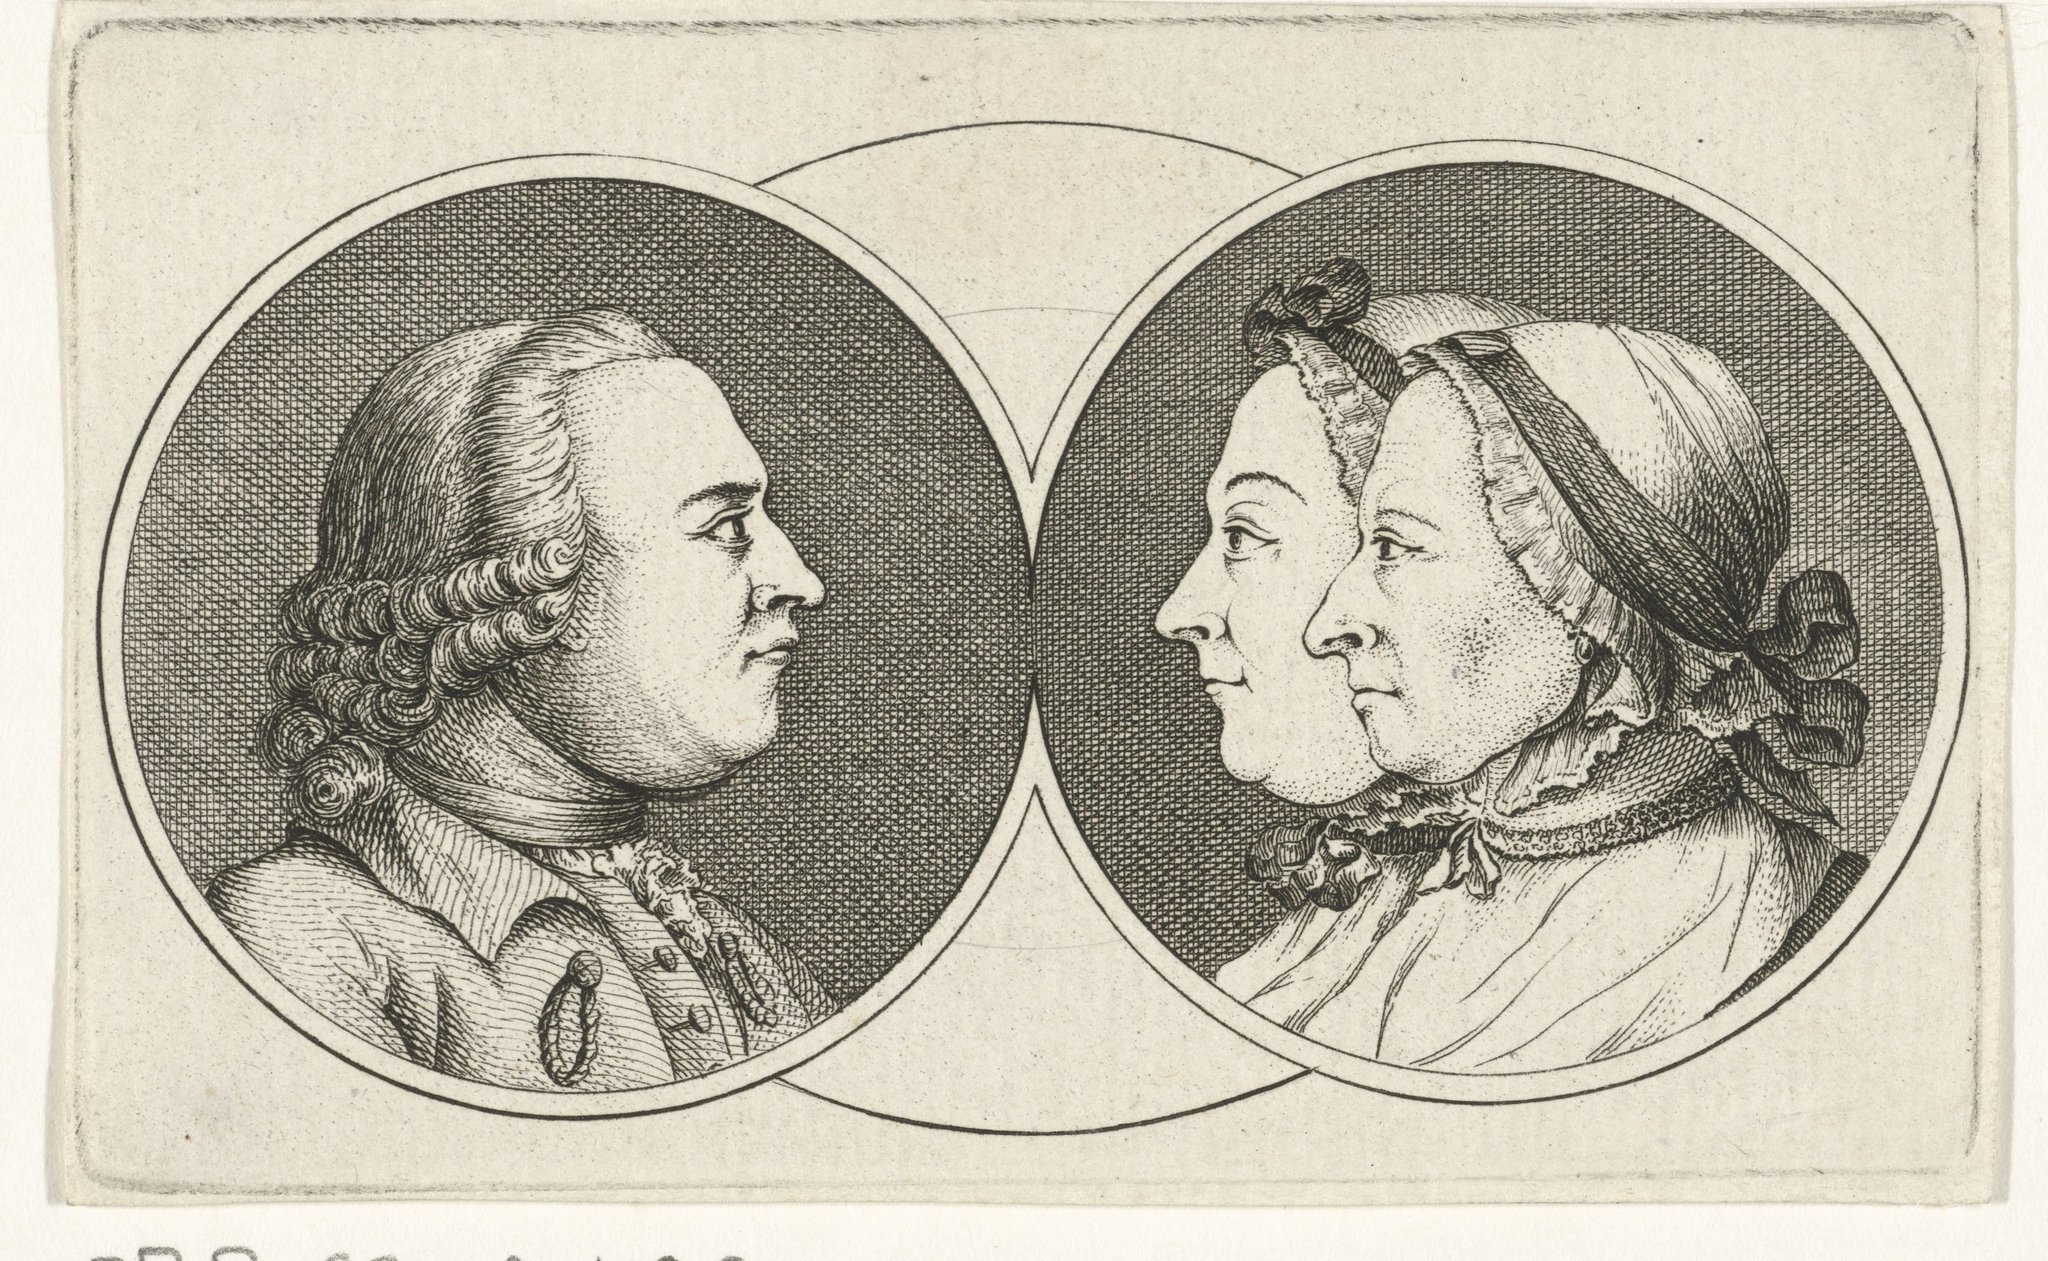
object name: print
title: Portretten van Caspar Philips Jacobsz., zijn echtgenote Margaretha Elisabeth Konsé-Philips en hun dochter Anna Elisabeth Philips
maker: anna elisabeth philips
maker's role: print maker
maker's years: 1757-1819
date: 1766-1819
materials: paper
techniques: engraving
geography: amsterdam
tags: amsterdam, print maker, margaretha elisabeth philips-konsé, anna elisabeth philips, draughtsman, caspar jacobsz. philips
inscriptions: collector's mark: Lugt 2228